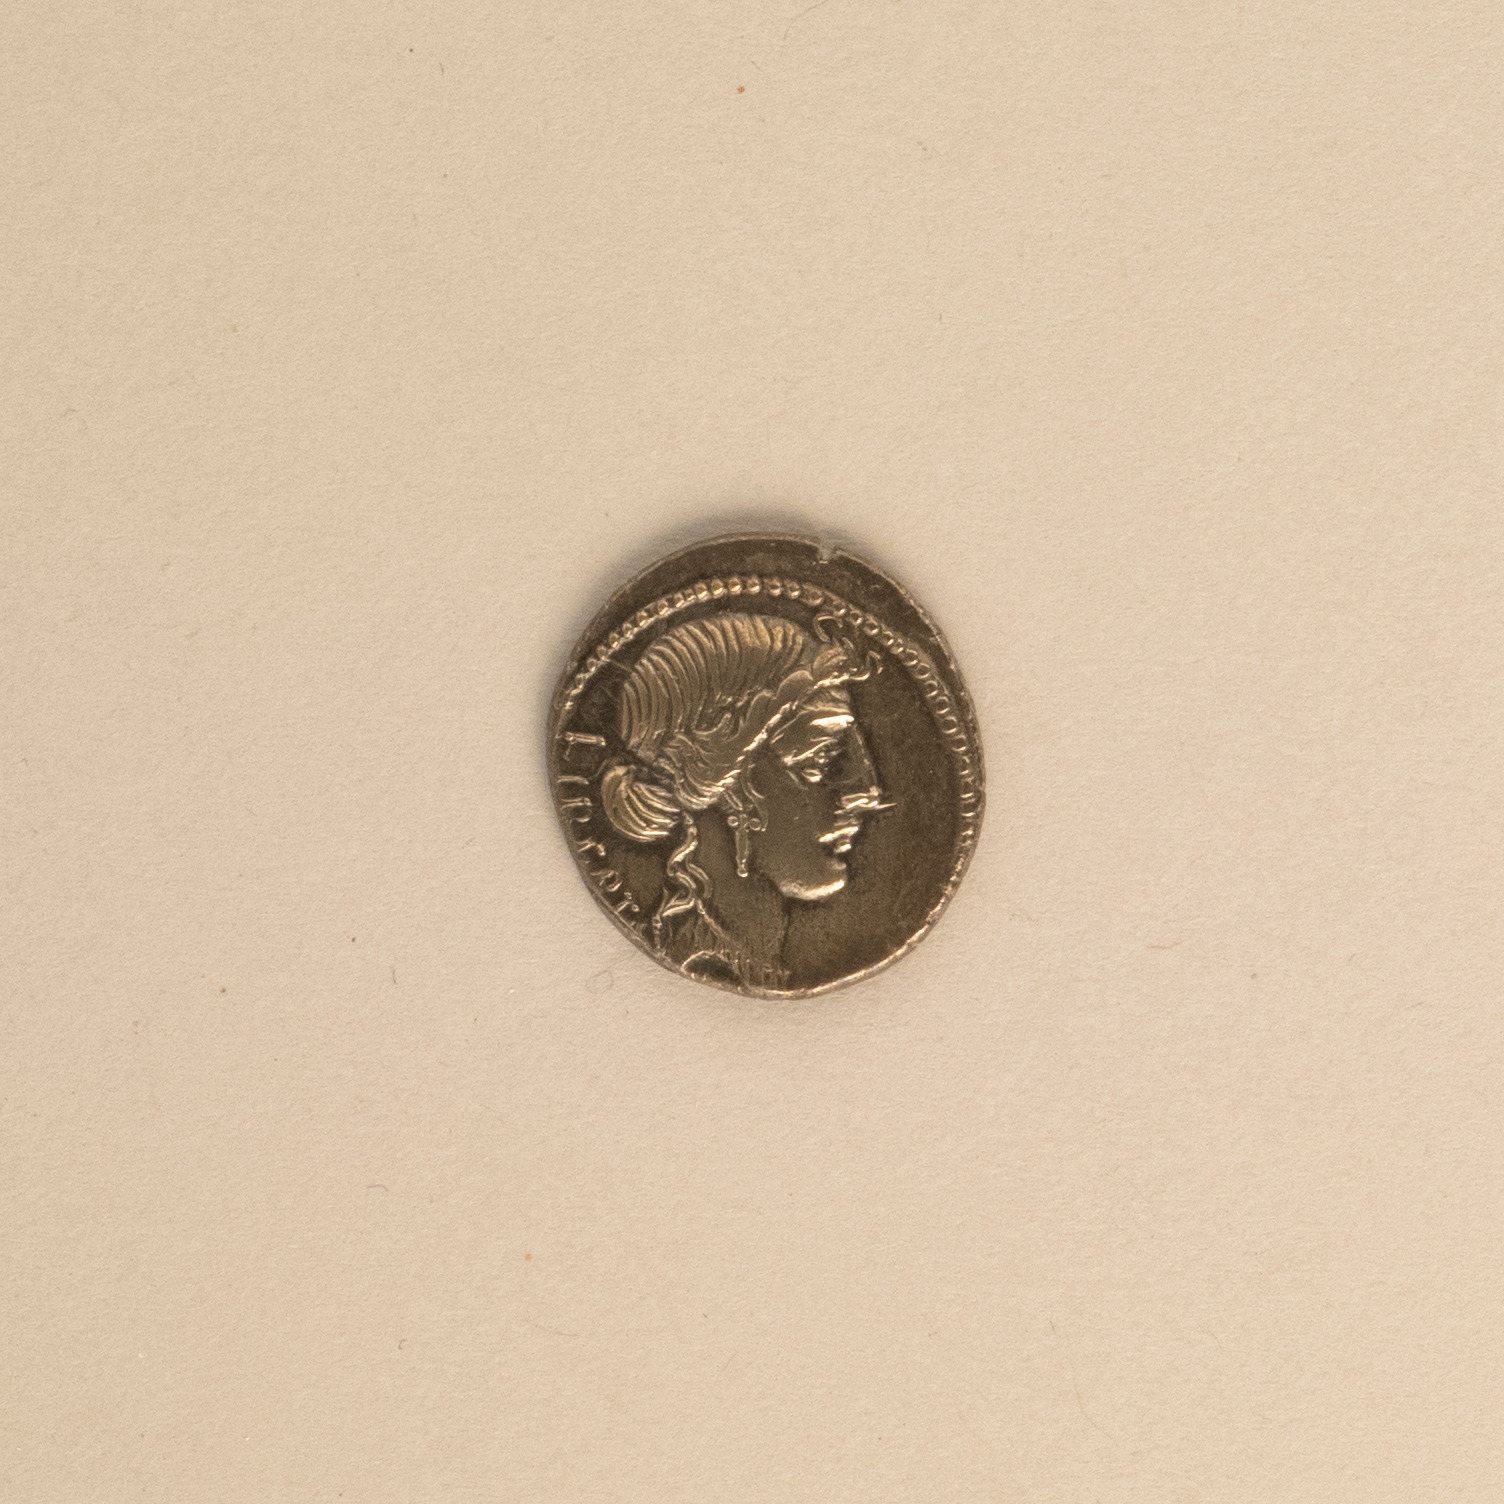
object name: denarius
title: Silver denarius of Brutus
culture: roman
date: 54 BCE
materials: silver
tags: men,profiles,coins